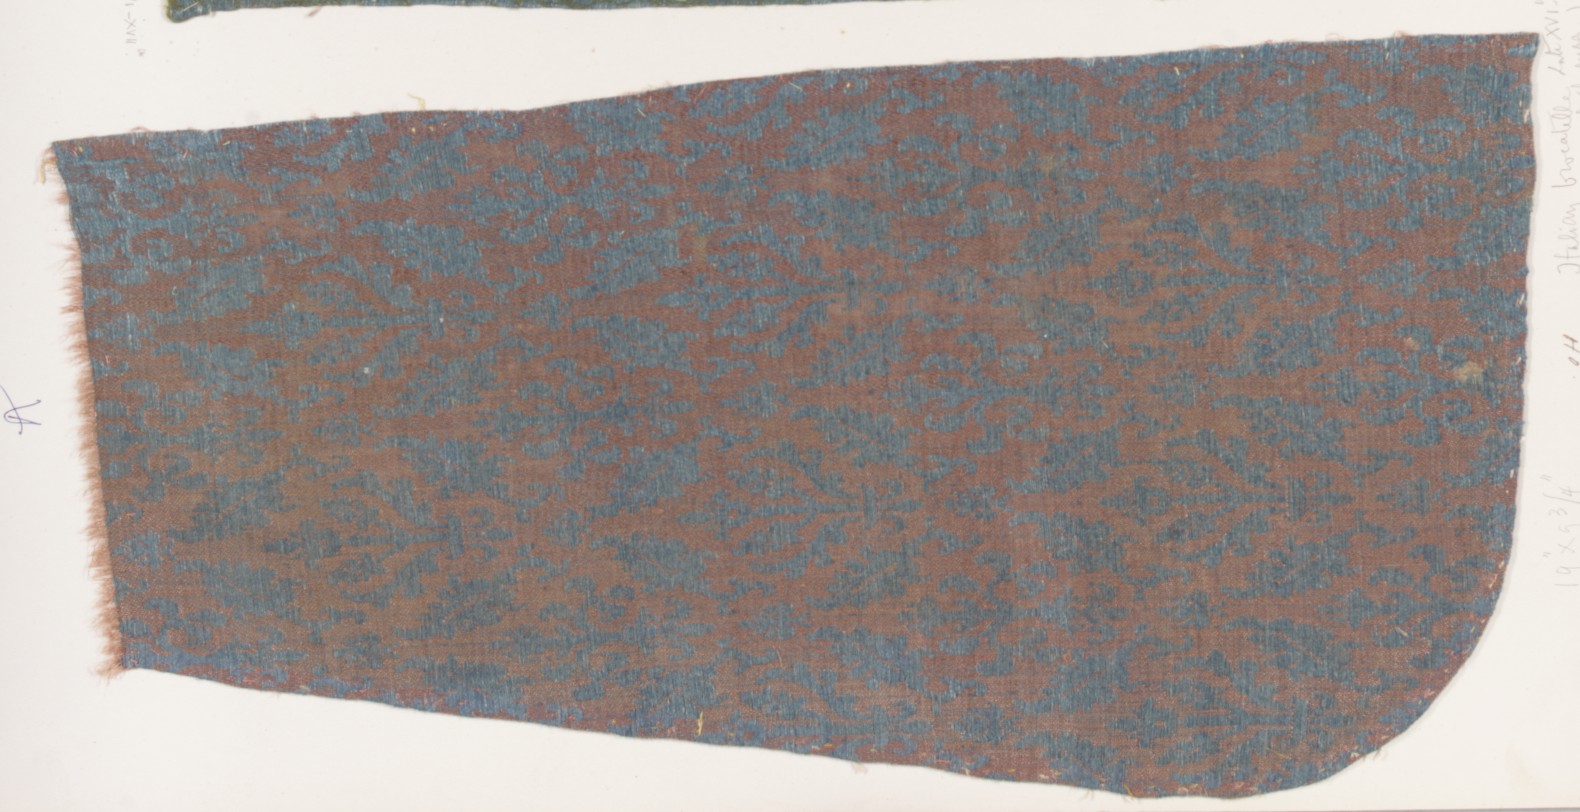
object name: fragment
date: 1567-1600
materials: silk